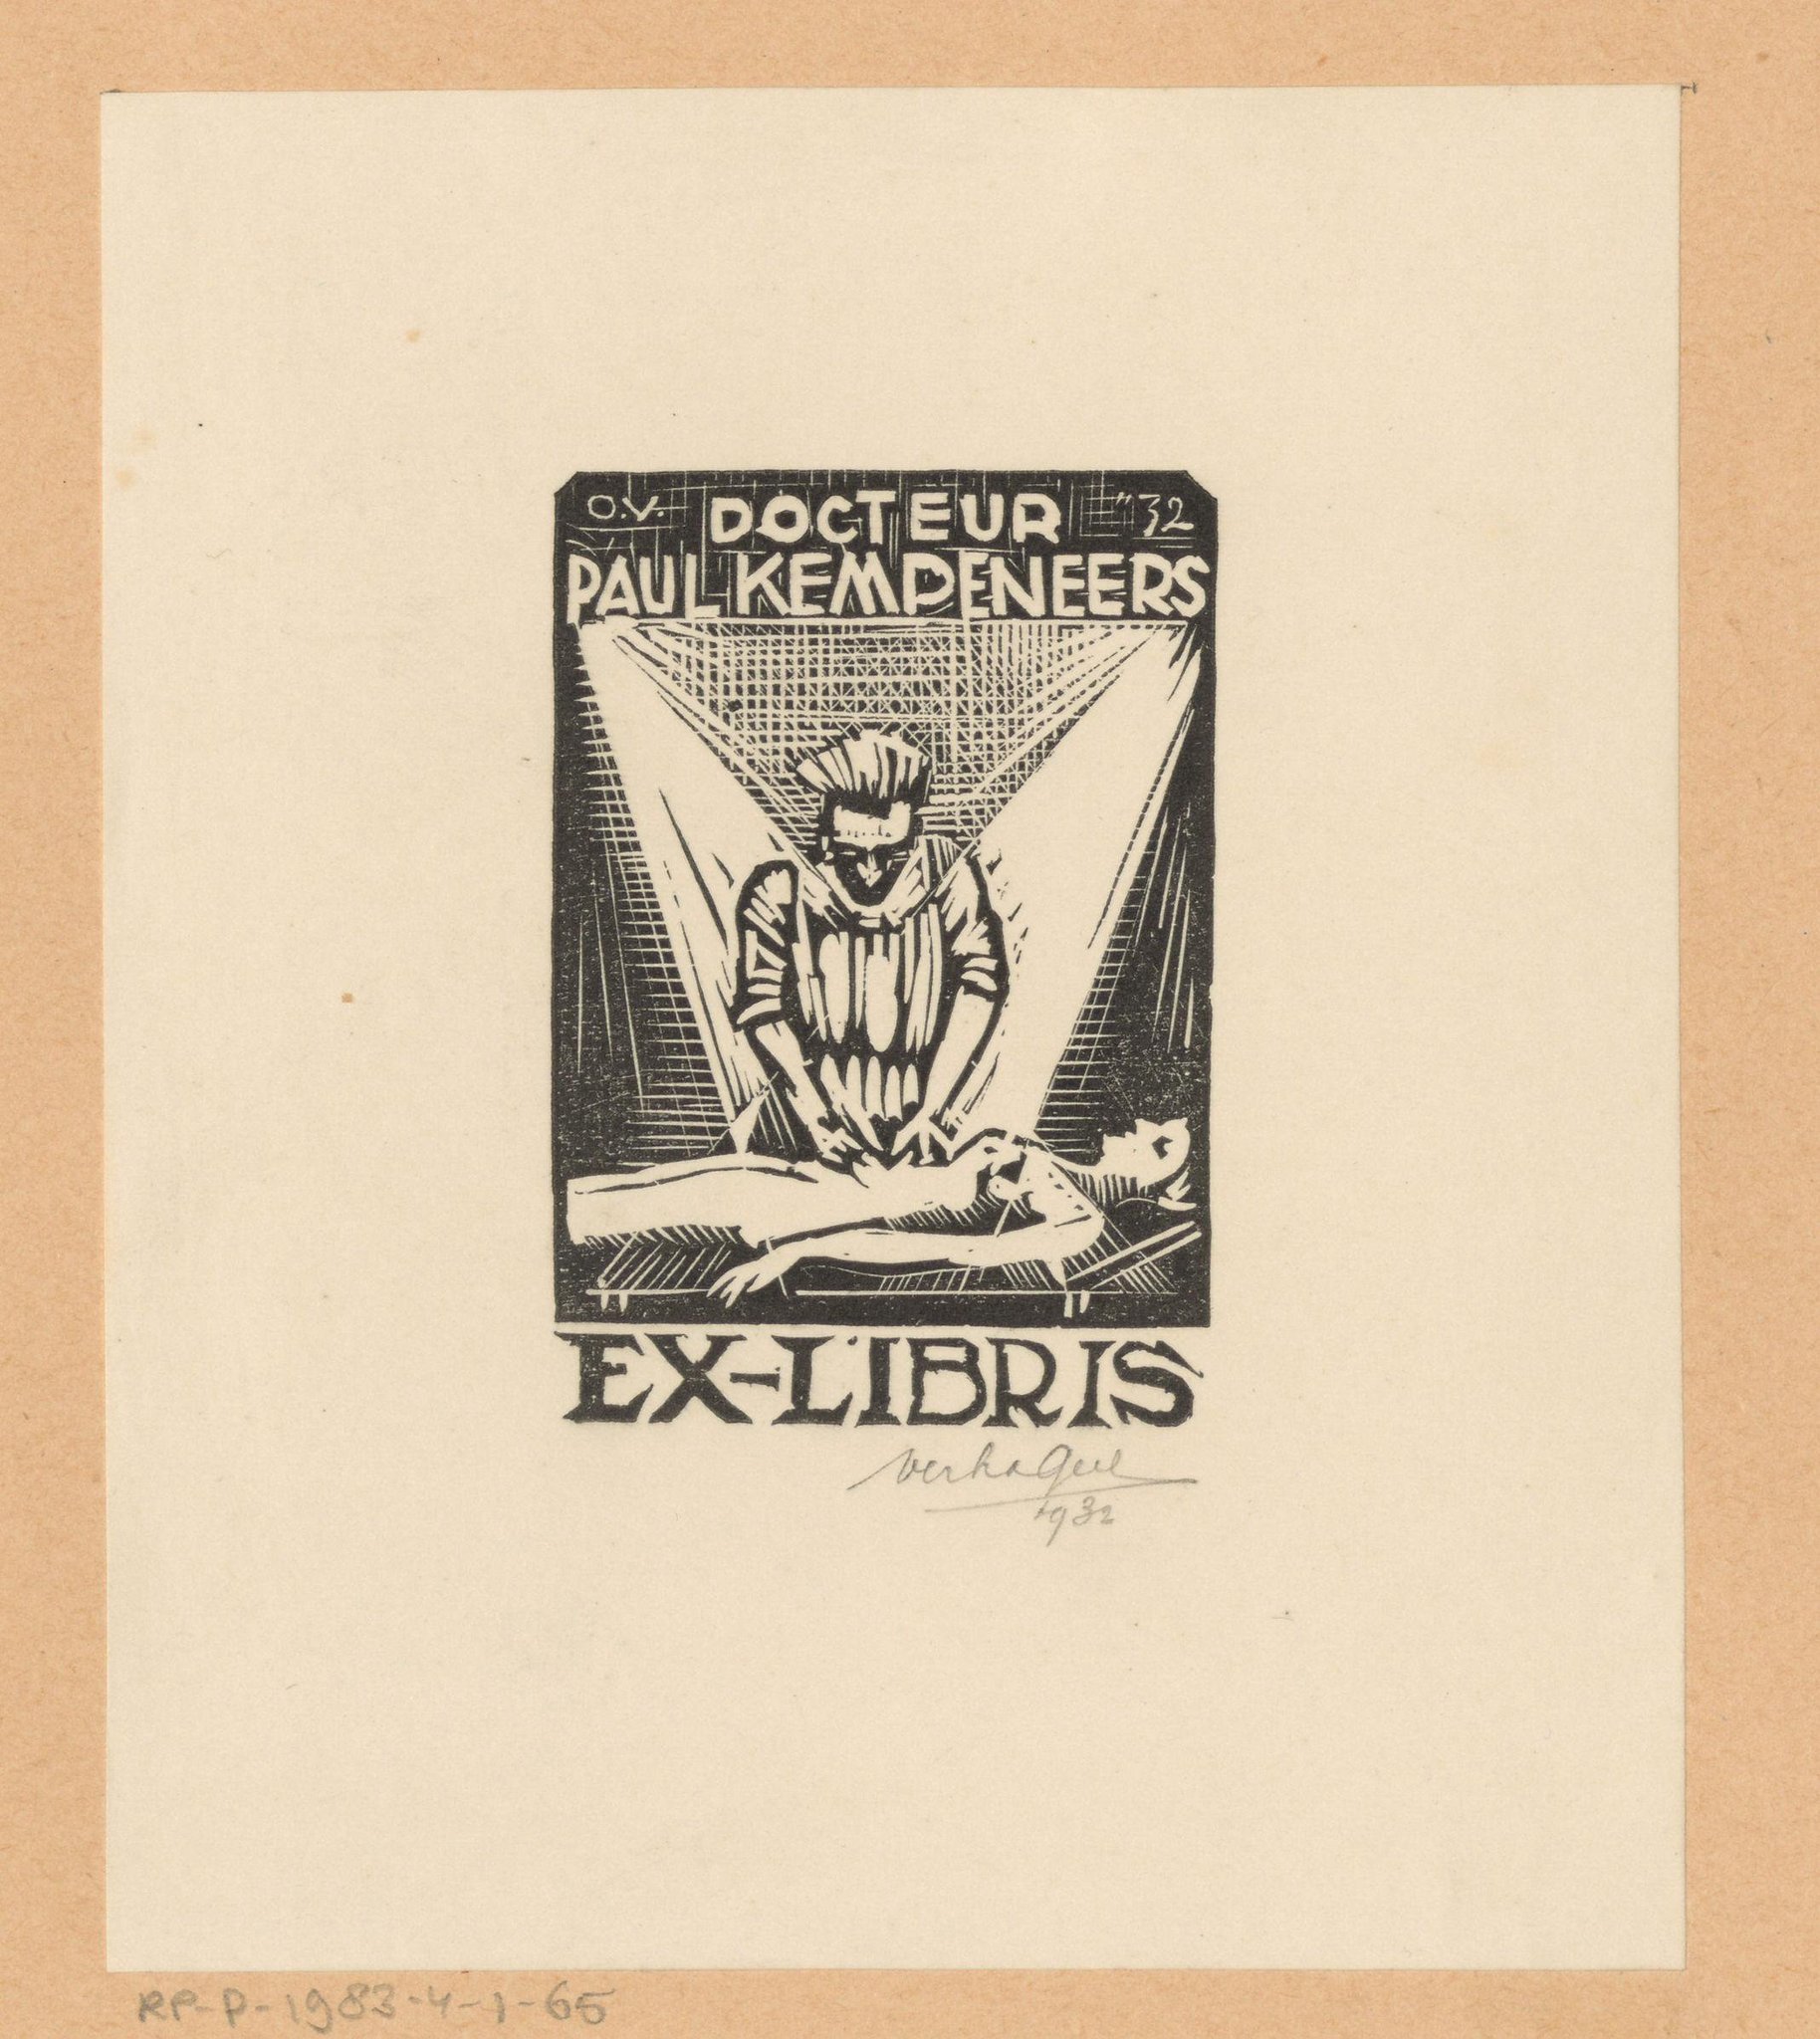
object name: bookplate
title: Ex-libris docteur Paul Kempeneers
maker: otto verhagen (i)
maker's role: draughtsman, print maker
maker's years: 1885-1951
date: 1932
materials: paper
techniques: woodcut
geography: netherlands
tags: paul kempeneers, physician, doctor, operation, surgery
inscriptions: inscription: ‘Houtsnede (Kops palmhout) (...) 1933/ Los Angeles.’, signature and date: ‘Verhagen/ 1932’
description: Voorstelling is een portret van de eigenaar van het ex libris, een chirurg. Het ontwerp werd door Verhagen ingestuurd voor de 9th Annual Exhibition of the Bookplate Association Internationa, mei 1933, Los Angeles.